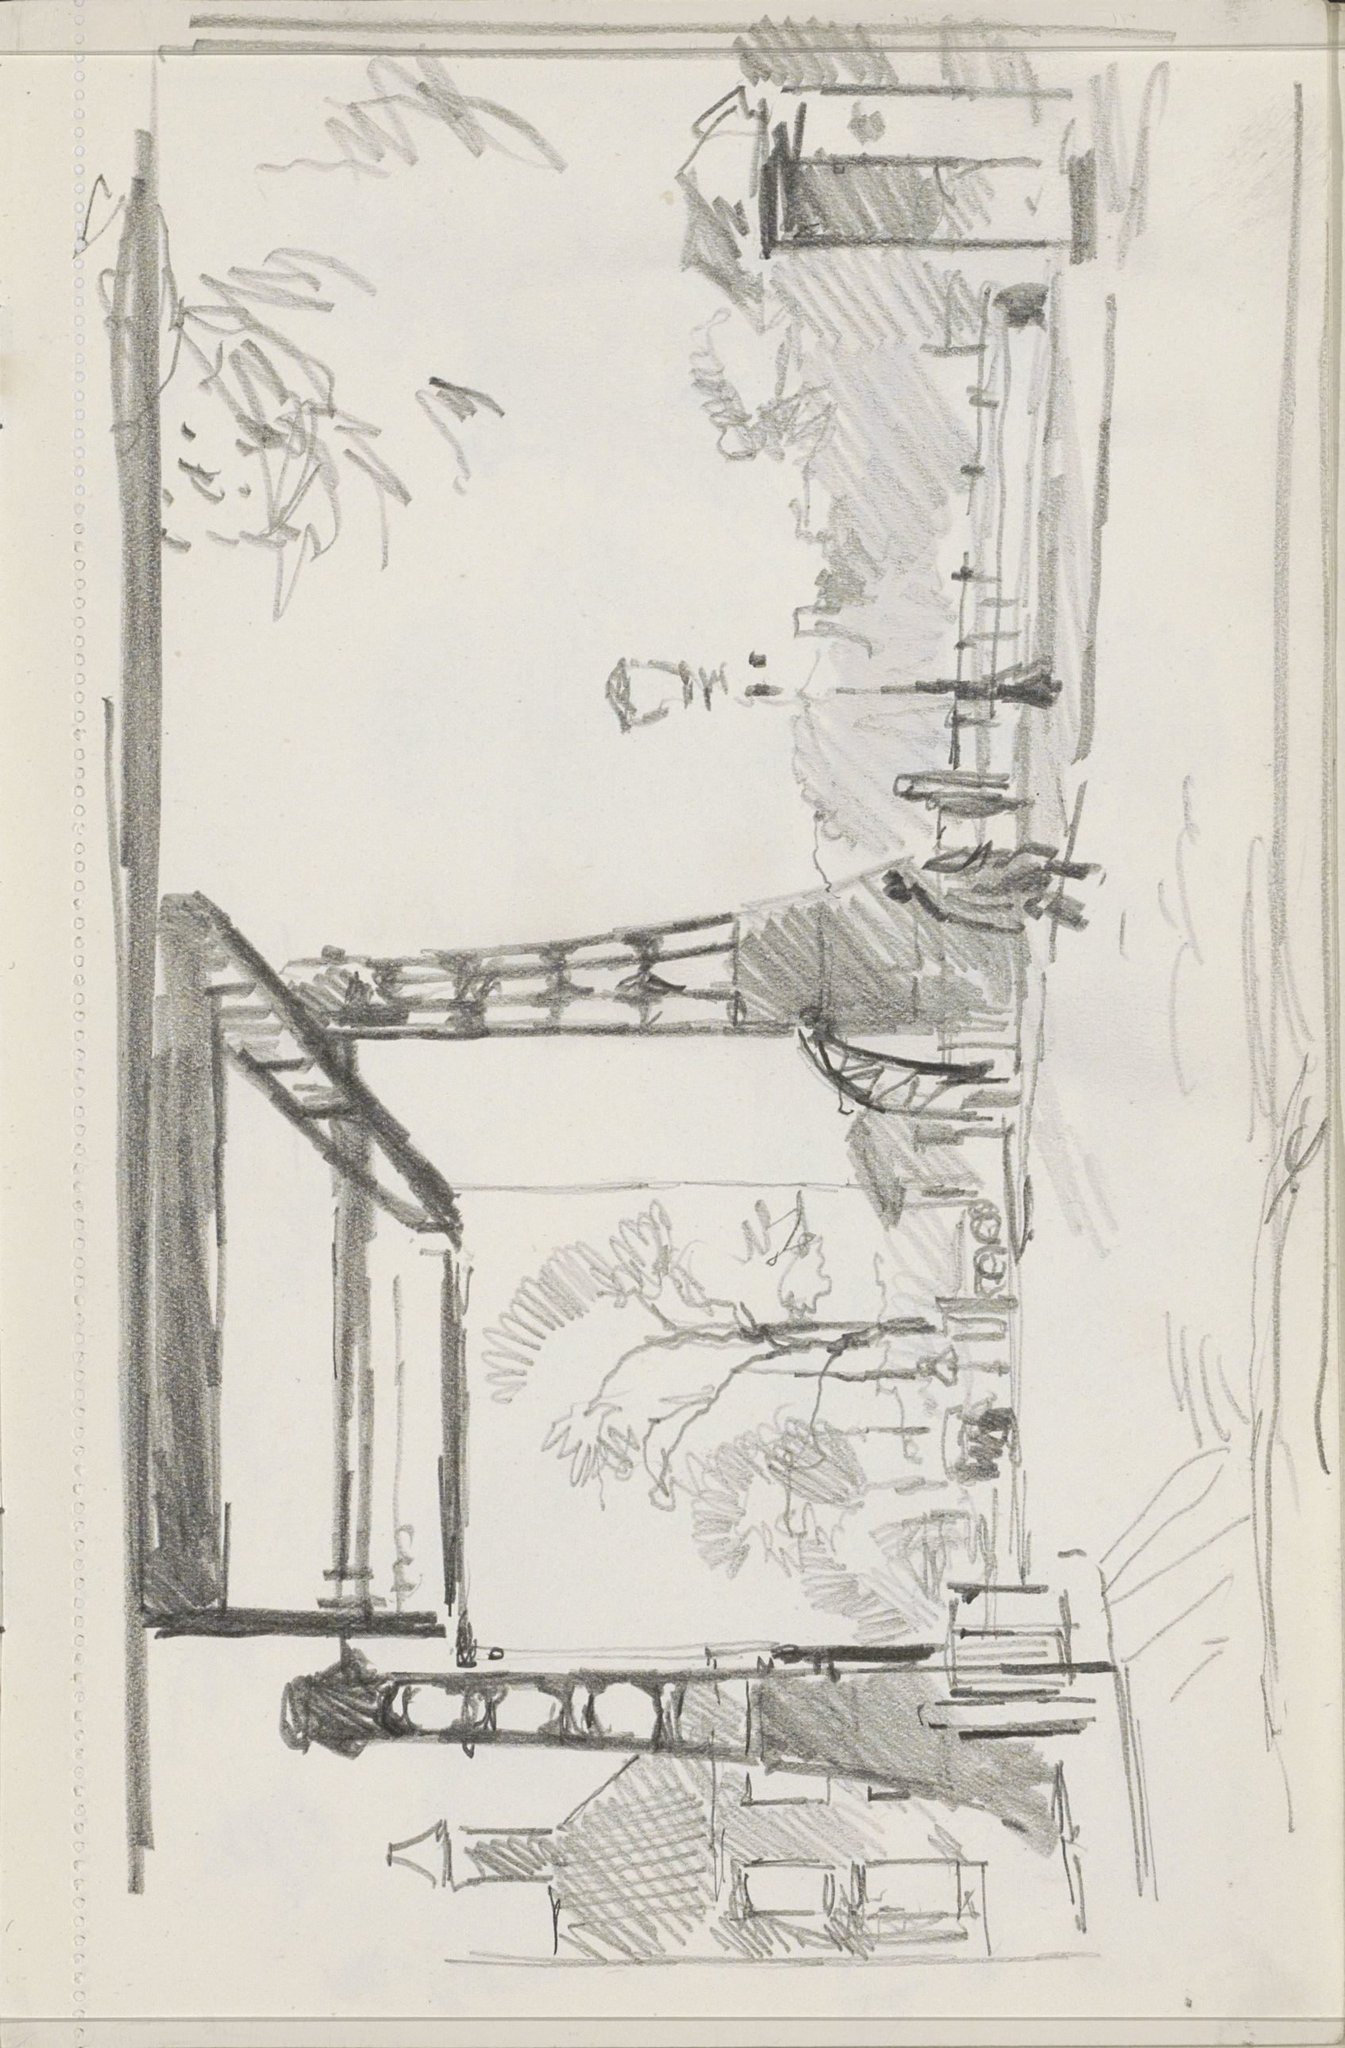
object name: sketchbook leaf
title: Ophaalbrug over een gracht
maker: cornelis vreedenburgh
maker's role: draughtsman, print maker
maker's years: 1880-1946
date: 1935-1936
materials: paper, pencil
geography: amsterdam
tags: bridge in city across river, canal, etc., amsterdam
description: Blad 4 recto uit een schetsboek met 73 bladen.